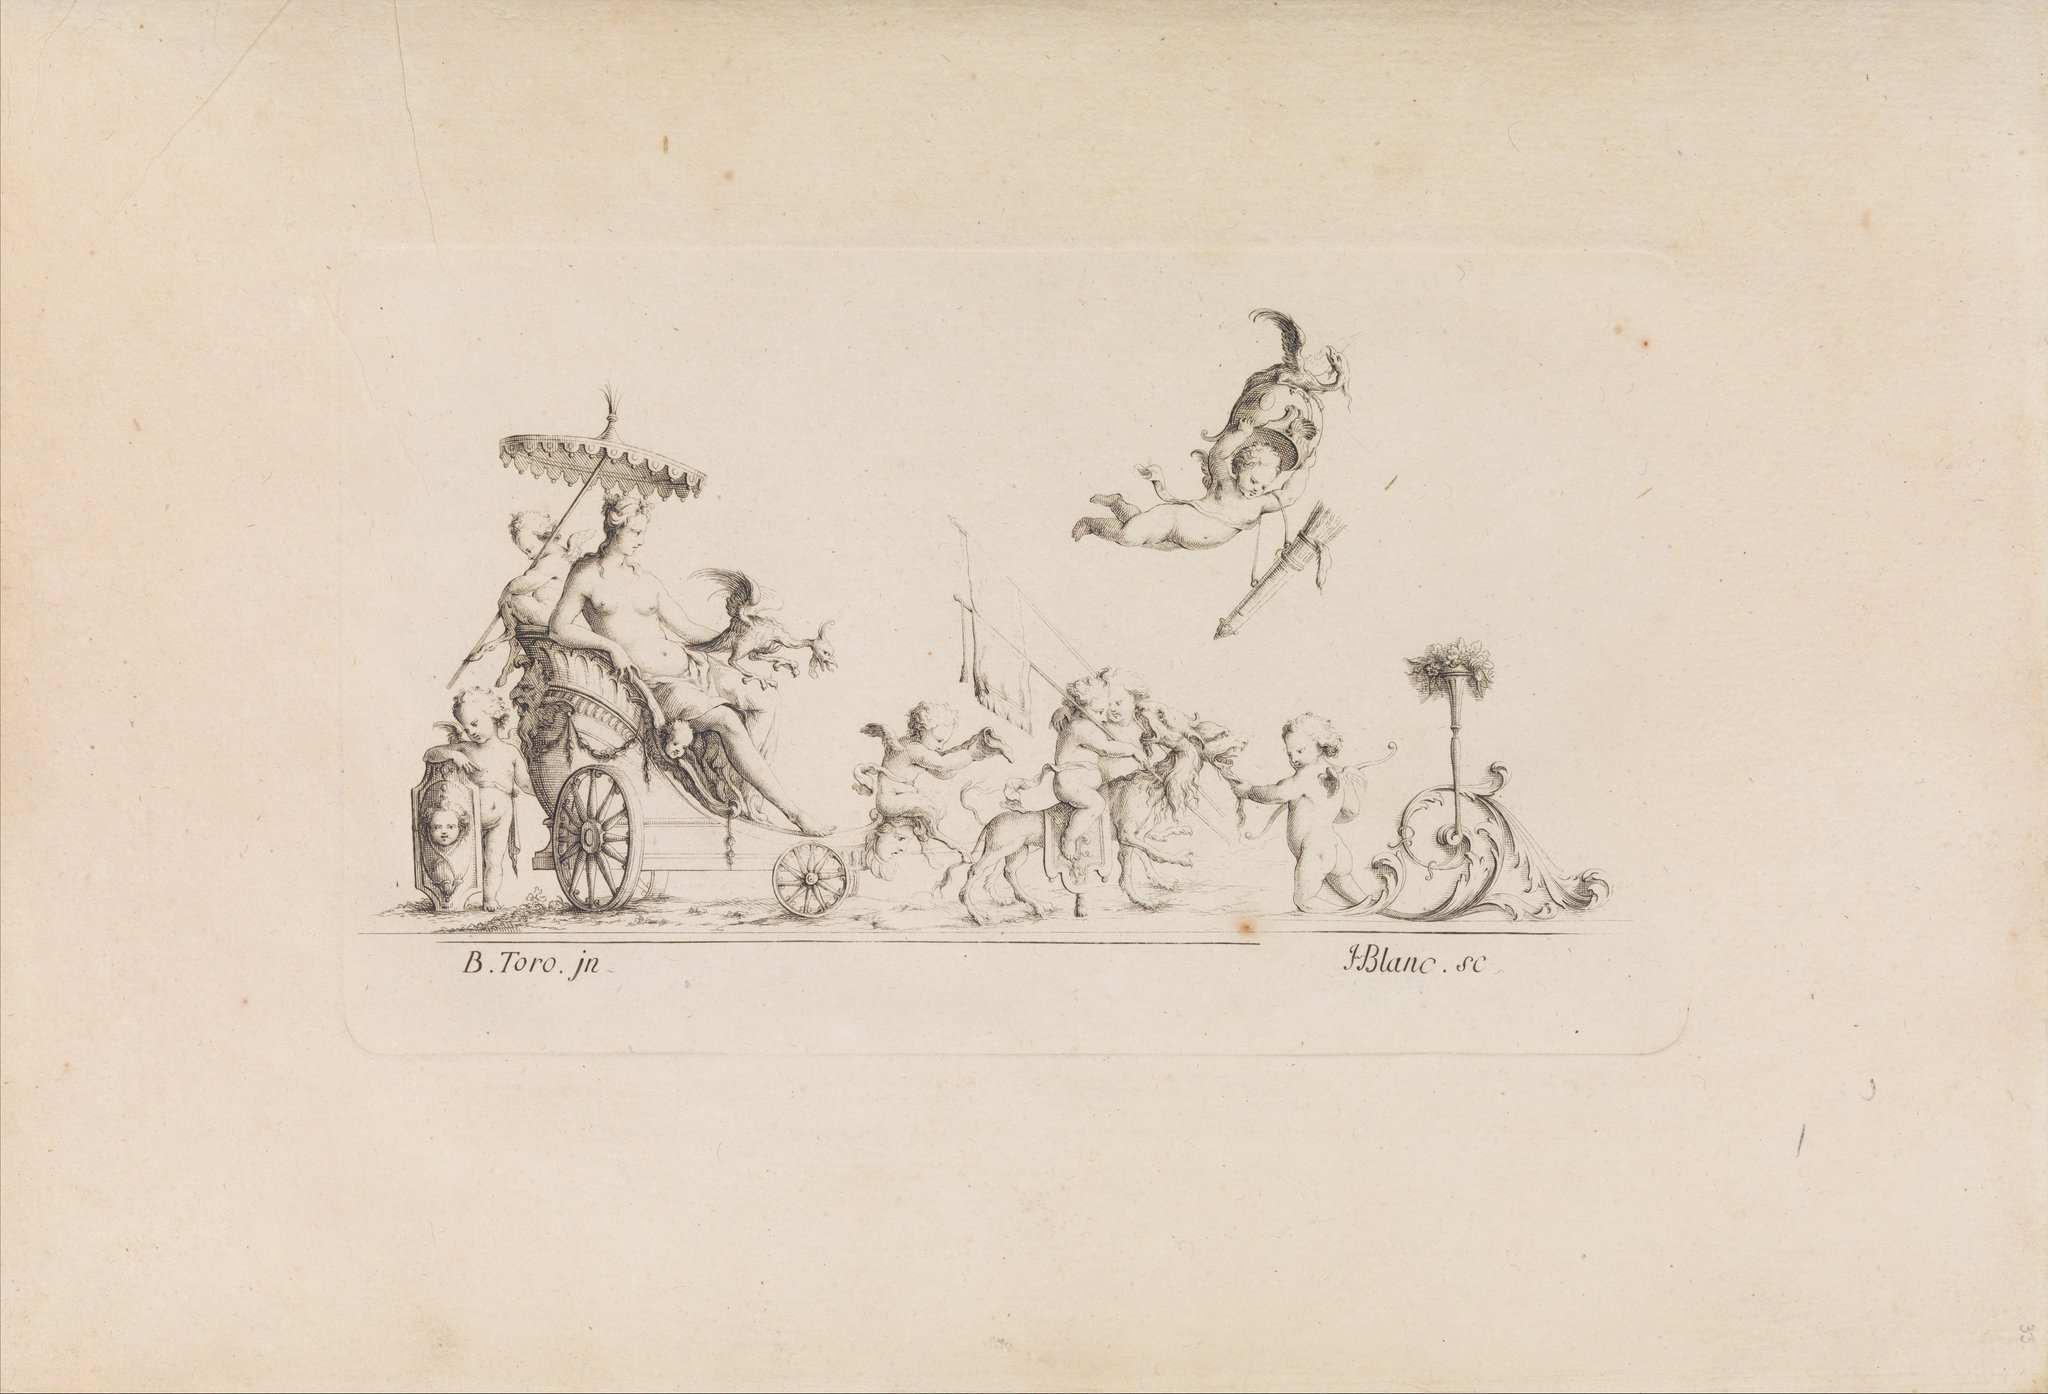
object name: album print ornament architecture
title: Desseins a Plusieurs Usages Inventés par M. B. Toro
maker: jean bernard toro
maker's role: designer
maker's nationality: french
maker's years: 1672-1731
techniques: etching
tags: female nudes,putti,dogs,chariots